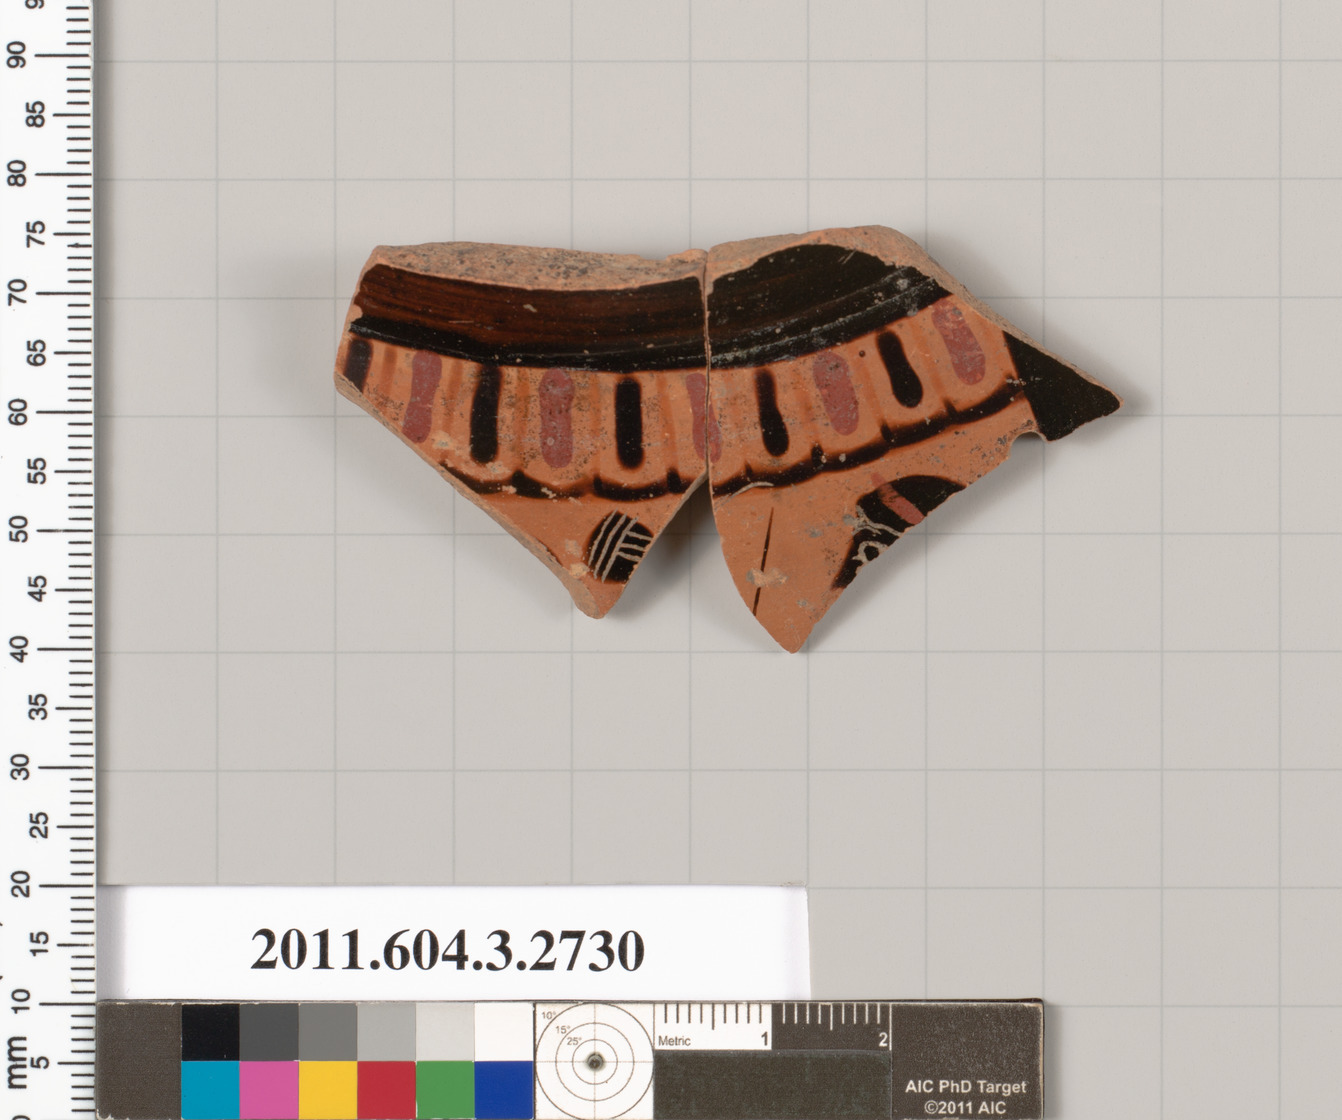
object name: oinochoe fragment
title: Terracotta fragment of an oinochoe (jug)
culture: greek, attic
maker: burgon group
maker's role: artist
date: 575-551 BCE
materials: terracotta